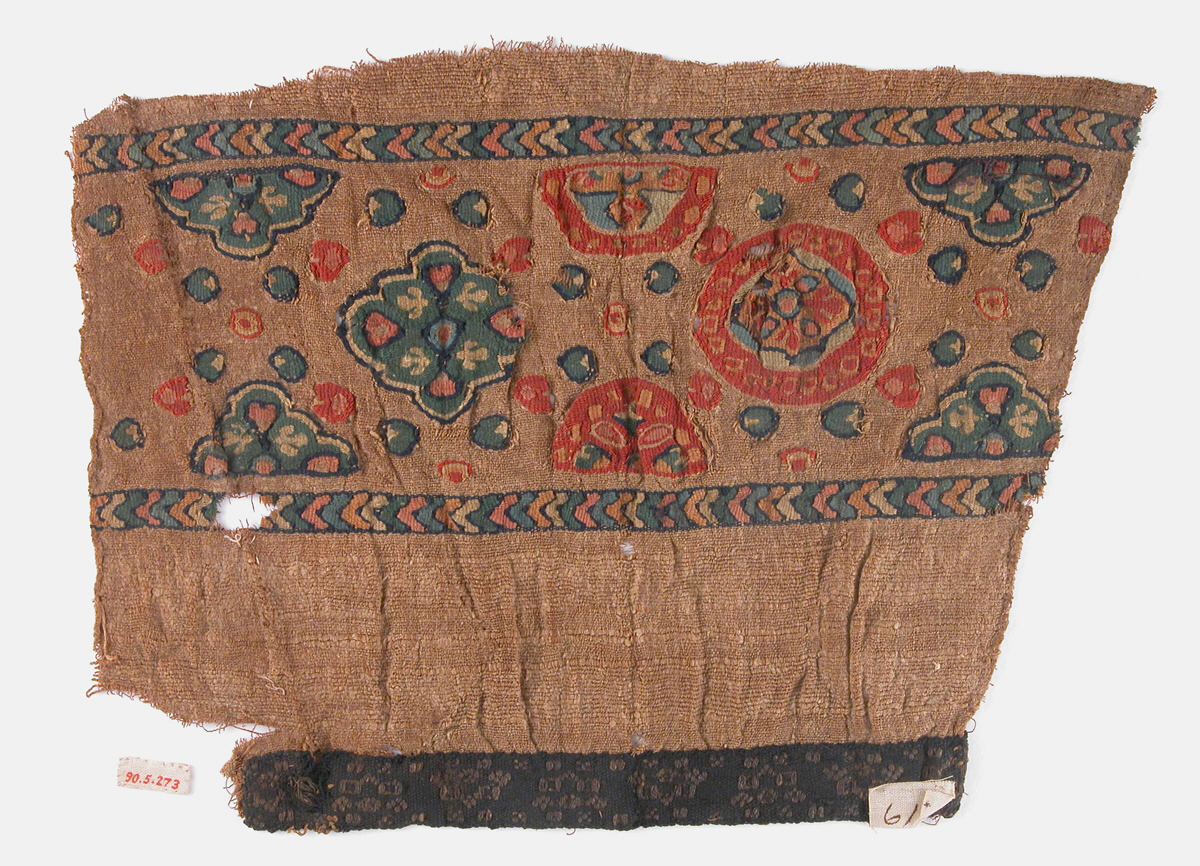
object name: textile fragment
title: Sleeve Fragment with Floral Motives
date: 501-900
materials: linen, wool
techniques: weave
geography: egypt